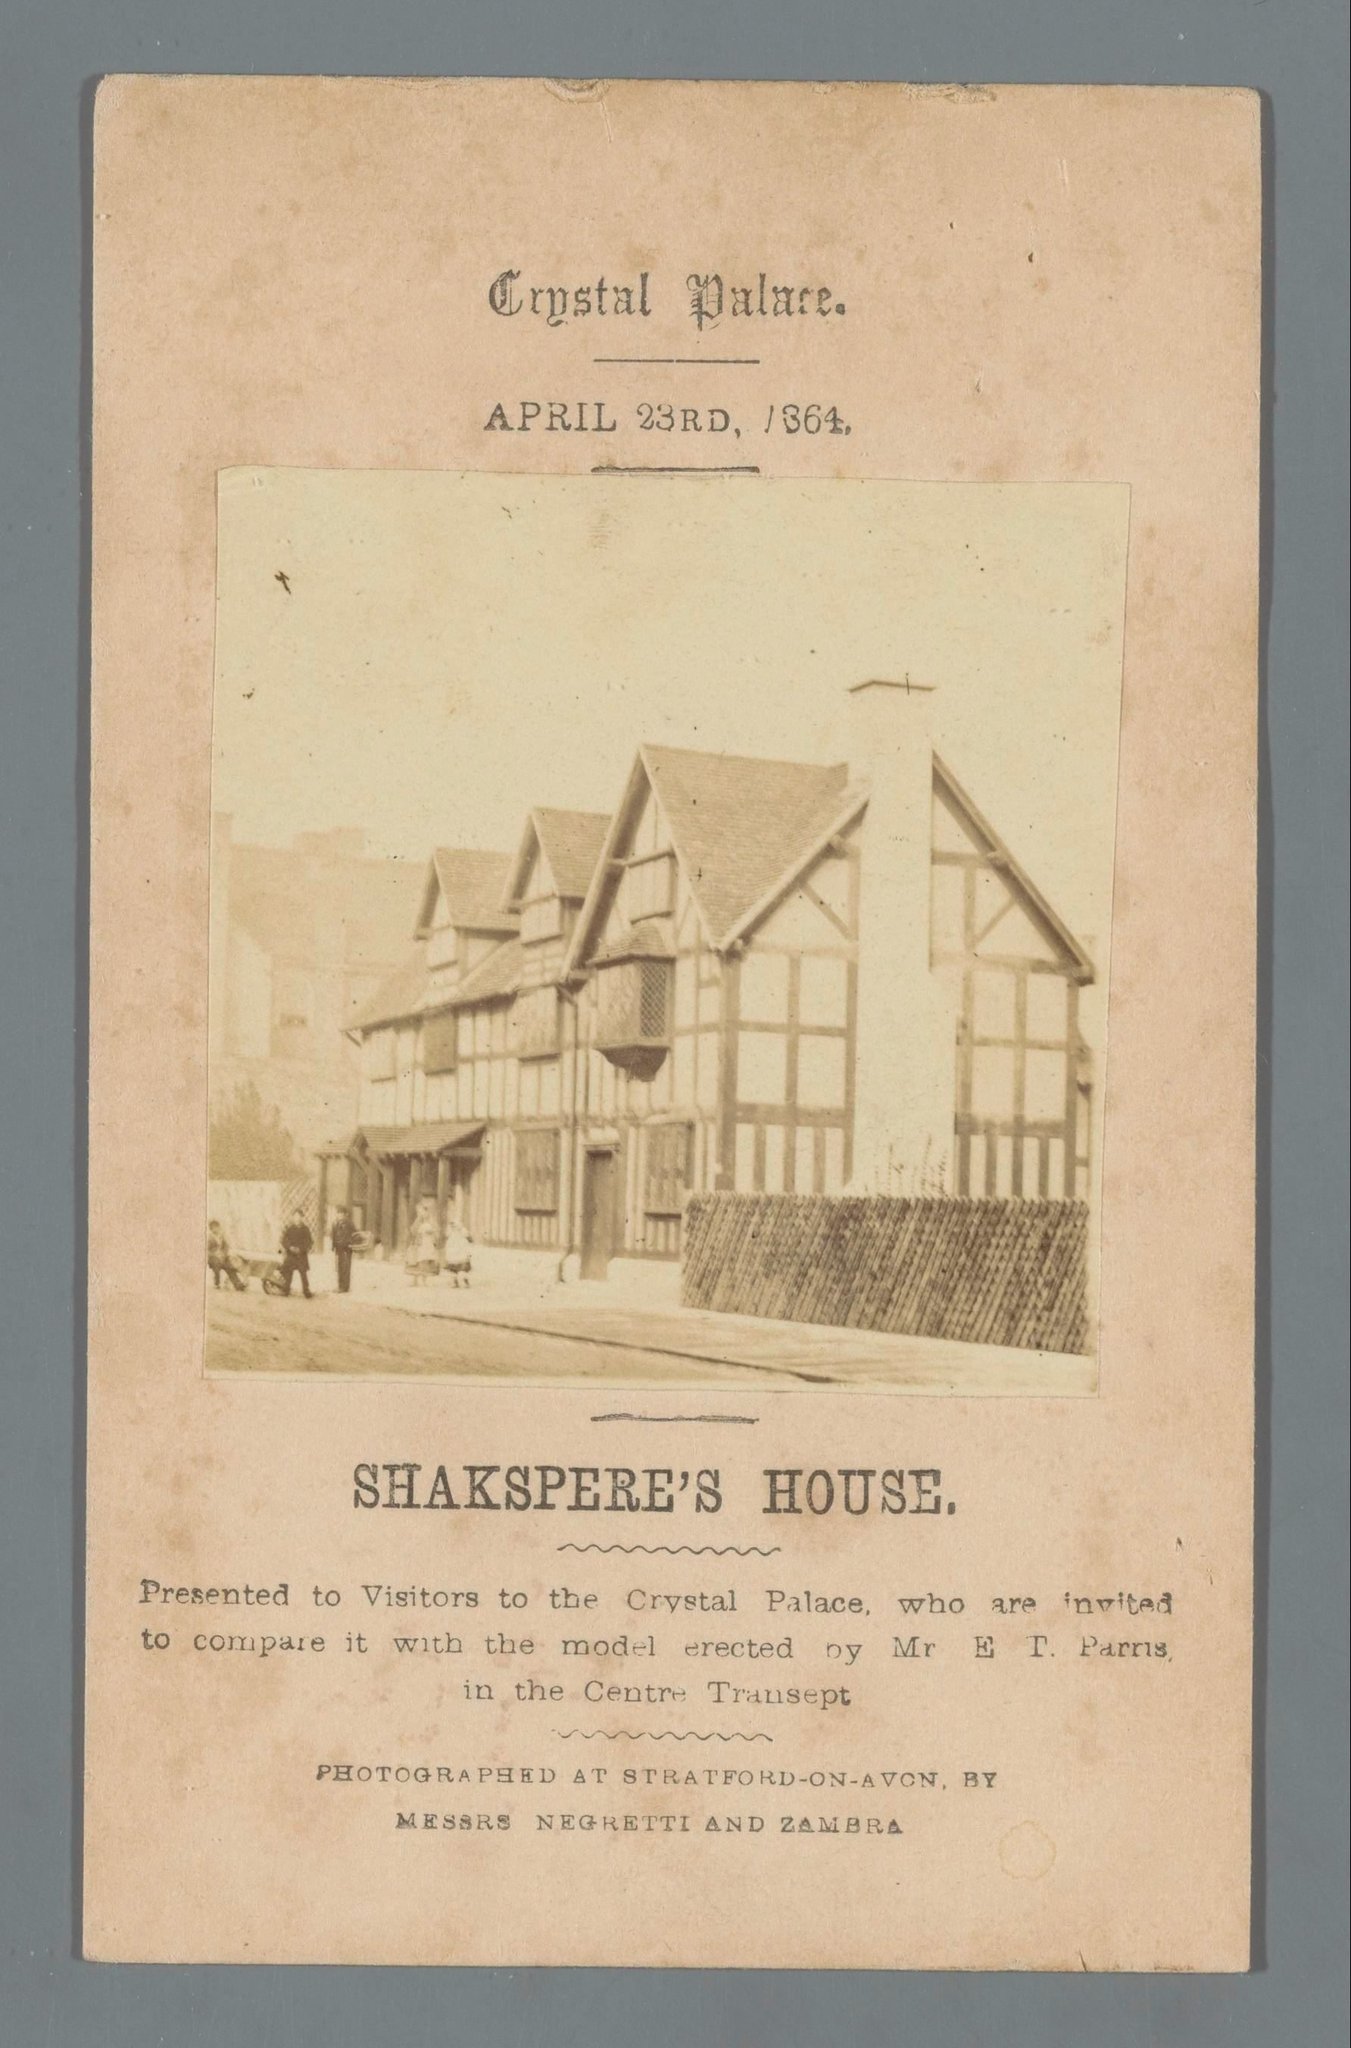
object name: carte de visite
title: Shakespere's House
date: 1864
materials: cardboard, paper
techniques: albumen print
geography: london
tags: william shakespeare, civic architecture; edifices; dwellings, england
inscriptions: annotation: ‘Crystal Palace. // April 23RD, 1864 // SHAKSPERE’s HOUSE. // Presented to Visitors to the Crystal Palace, who are invited // to compare it with the model erected by Mr E.T. Parris // in the Centre Transept // PHOTOGRAPHED AT STRATFORD-ON-AVON, BY / MESSRS NEGRETTI AND ZAMBRA.’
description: Het geboortehuis van William Shakespeare, Henley Street, Stratford-upon-Avon, Groot-Brittannië (dienende ter vergelijking met het model dat door E.T. Parris was gebouwd in het Crystal Palace).